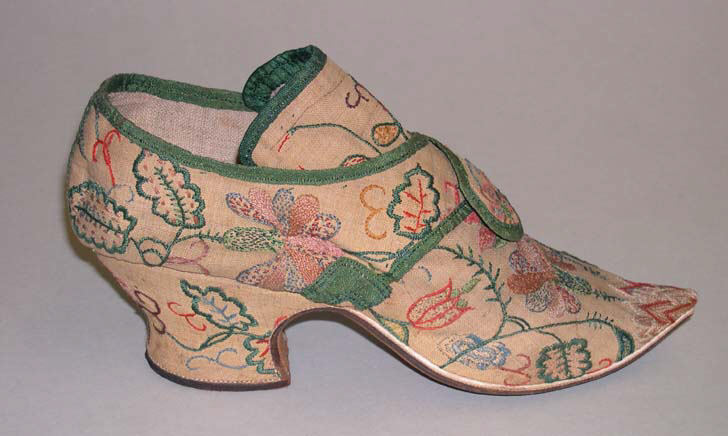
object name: shoe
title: Shoes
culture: british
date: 1700-1725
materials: silk